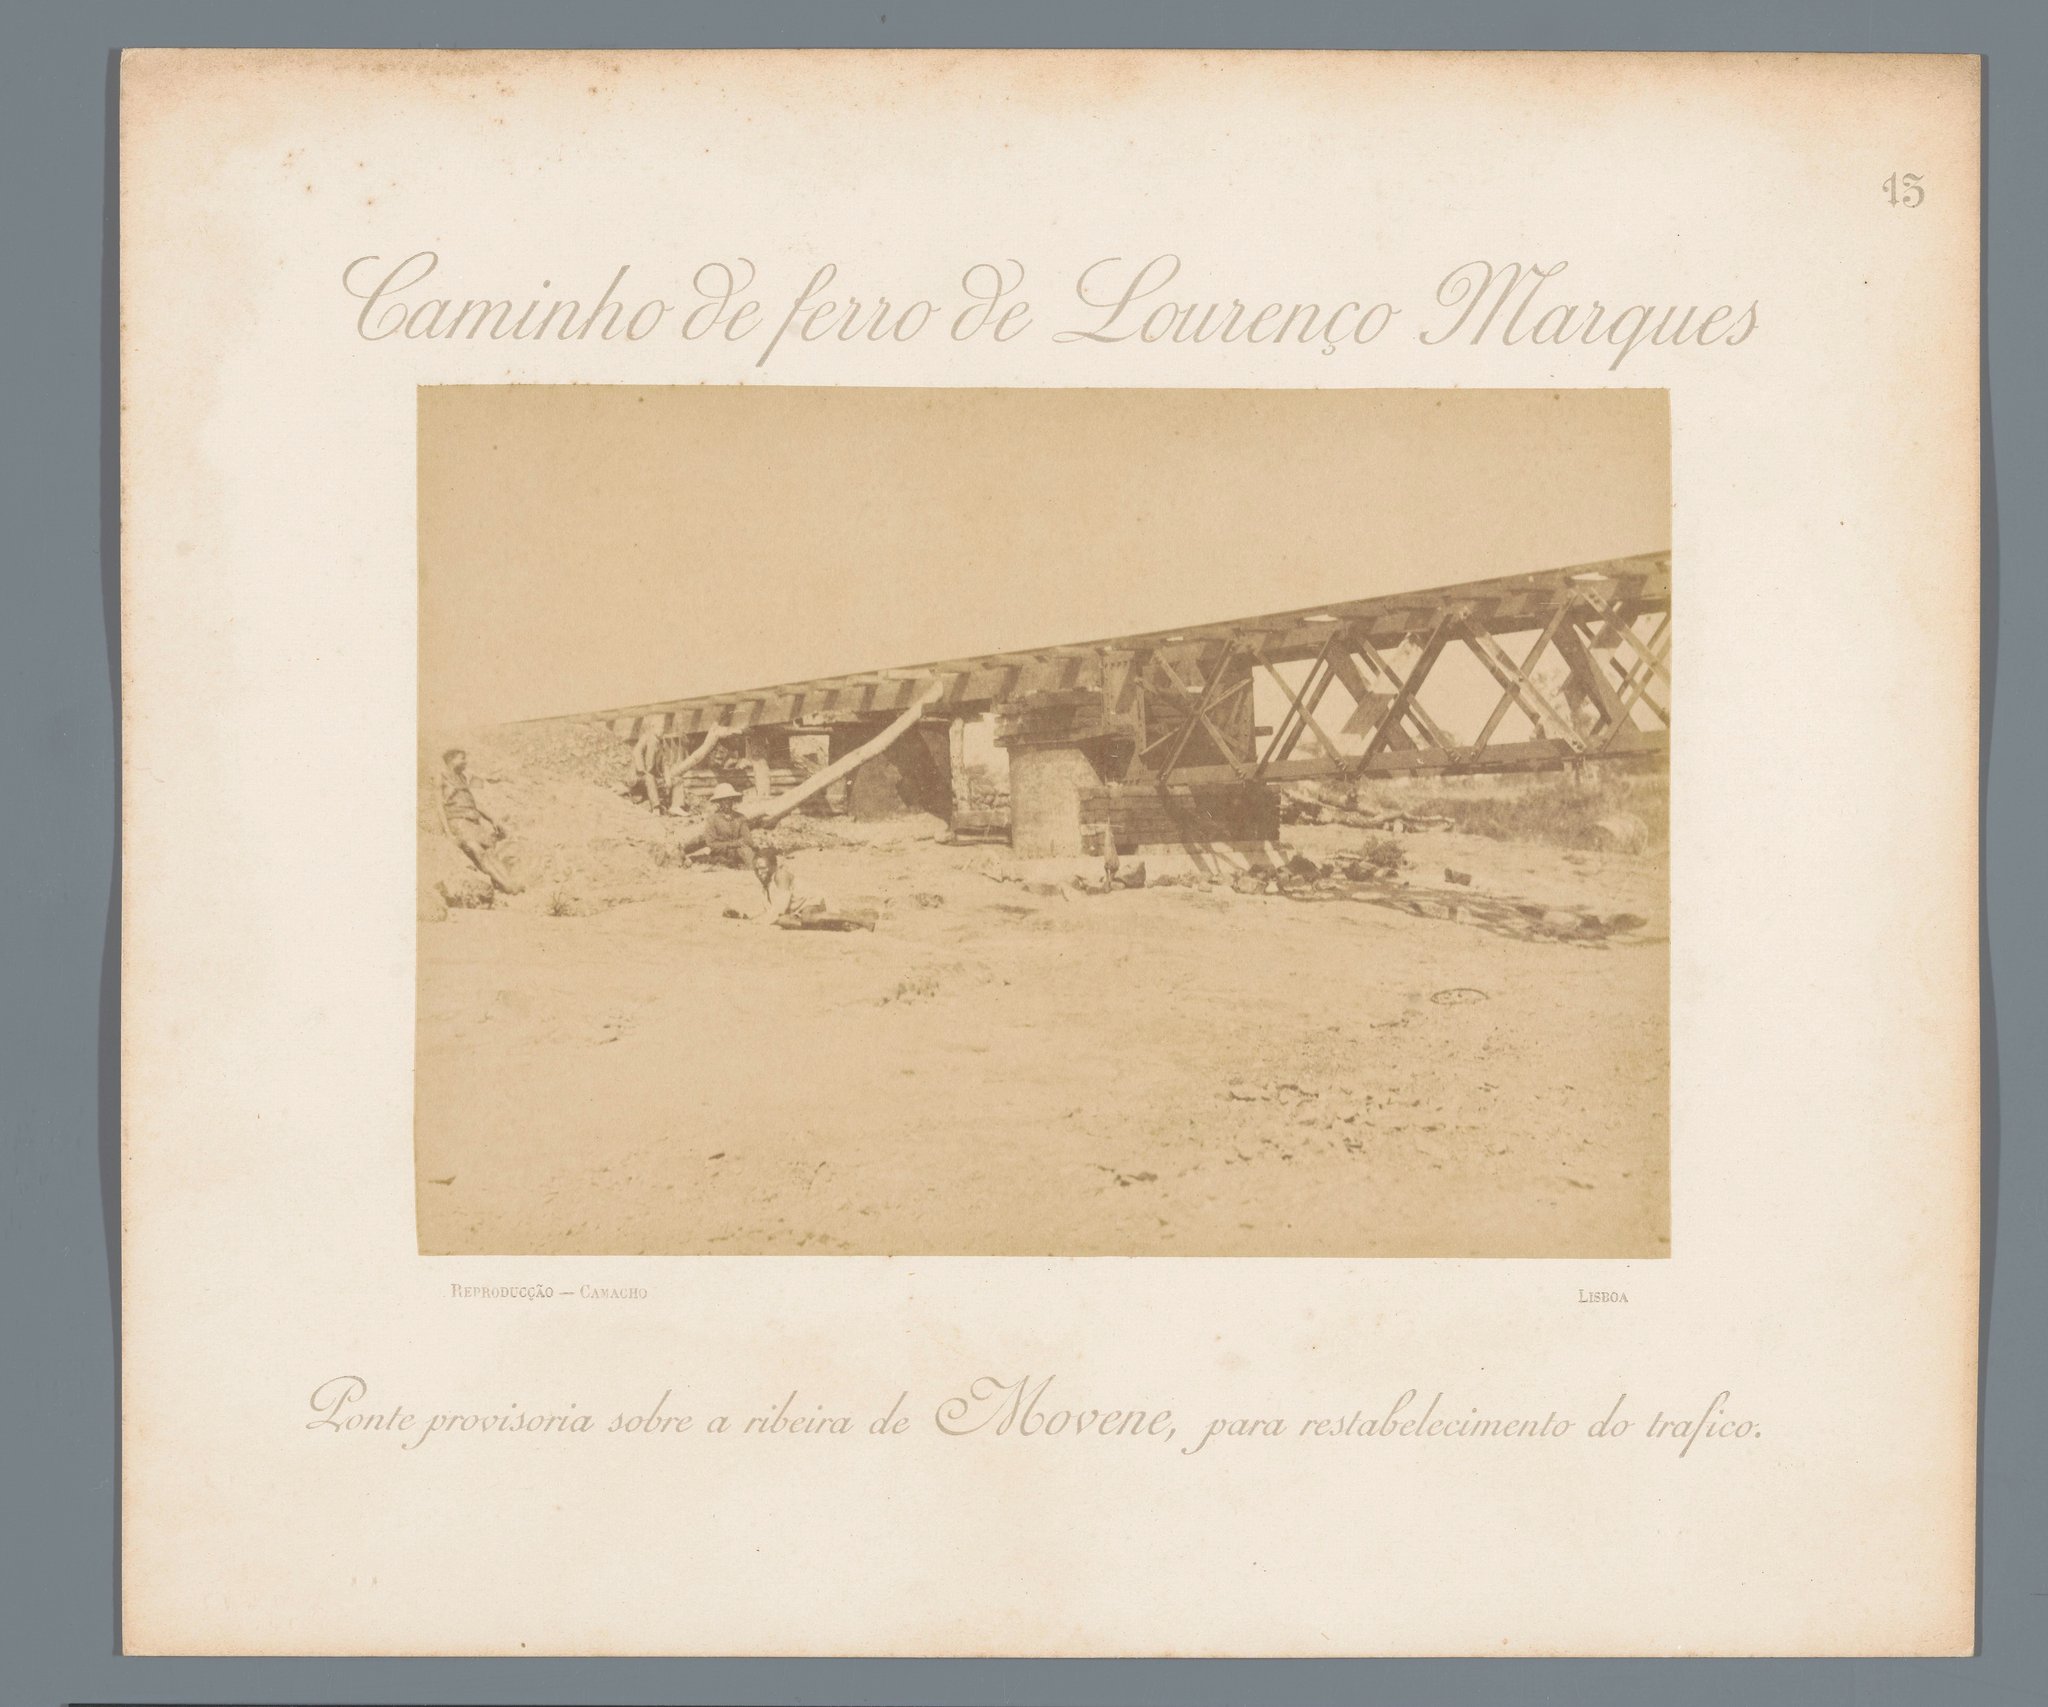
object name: photograph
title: Ponte provisoria sobre a ribeira Movene, para restabelecimento do trafico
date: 1889-1895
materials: photographic support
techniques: albumen print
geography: mozambique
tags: bridges by construction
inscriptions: number: ‘13’